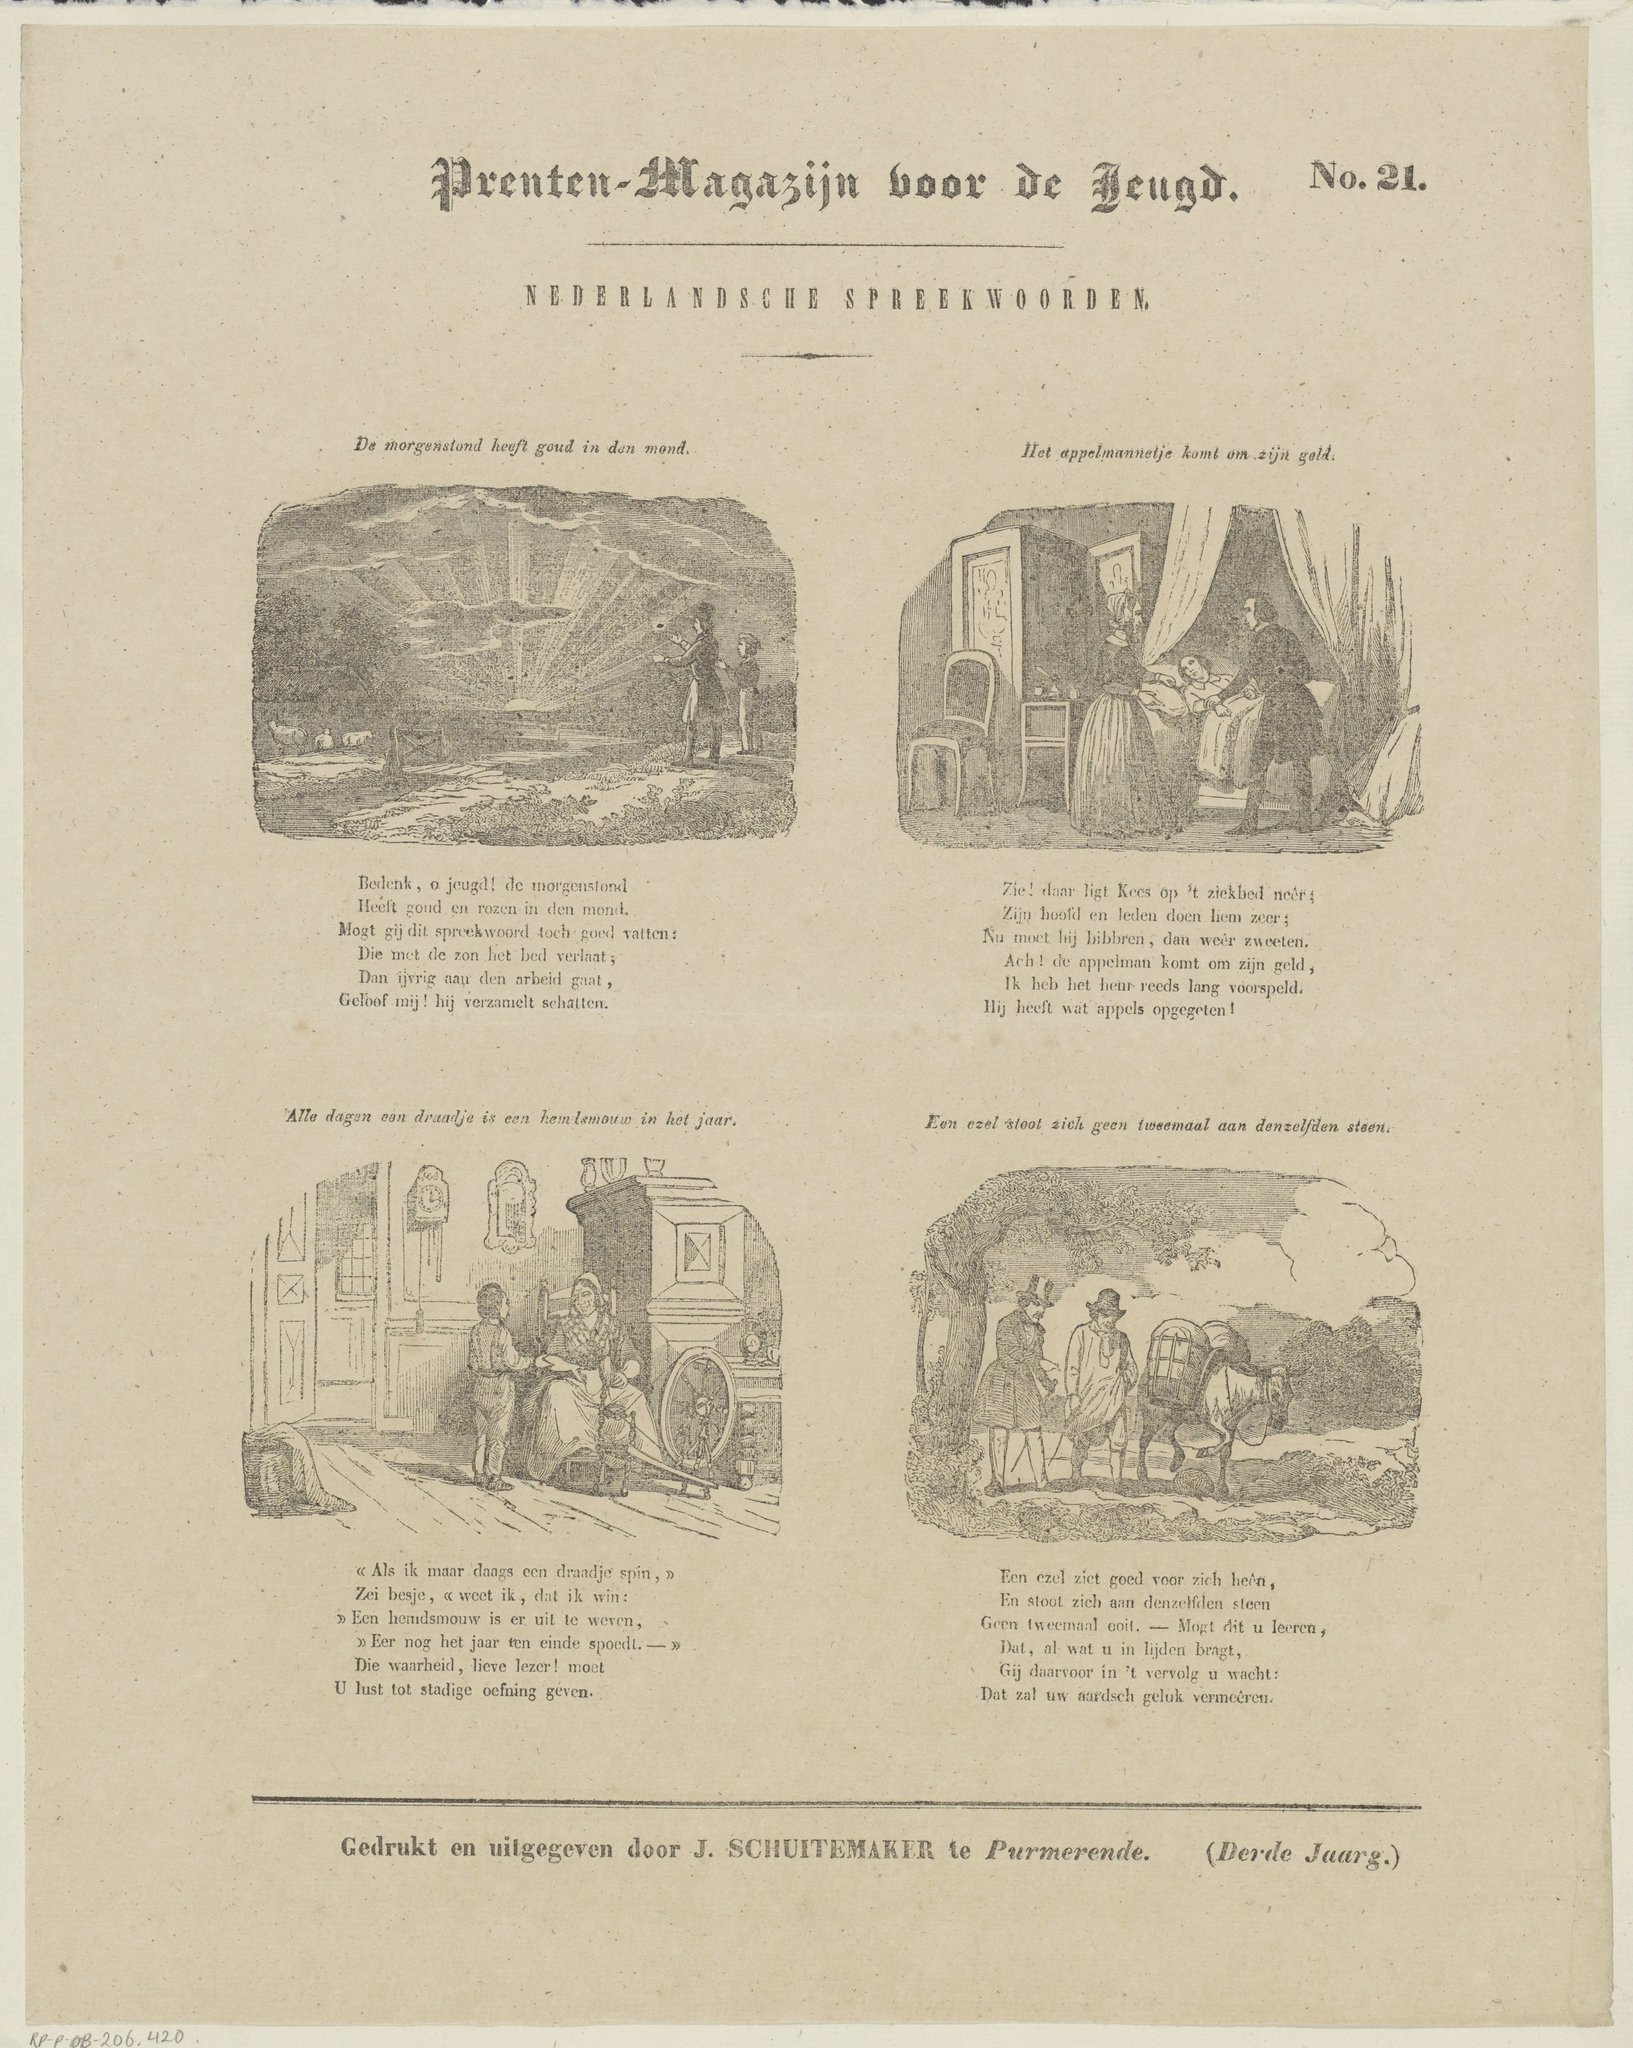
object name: print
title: Prenten-magazijn voor de jeugd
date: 1844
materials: paper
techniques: letterpress printing, engraving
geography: netherlands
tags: proverbs, sayings, etc.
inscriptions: collector's mark: Lugt 2760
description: Blad met 4 verbeeldingen van spreekwoorden. Boven elke voorstelling een titel en onder elke voorstelling een zesregelig vers. Genummerd rechtsboven: No. 21.